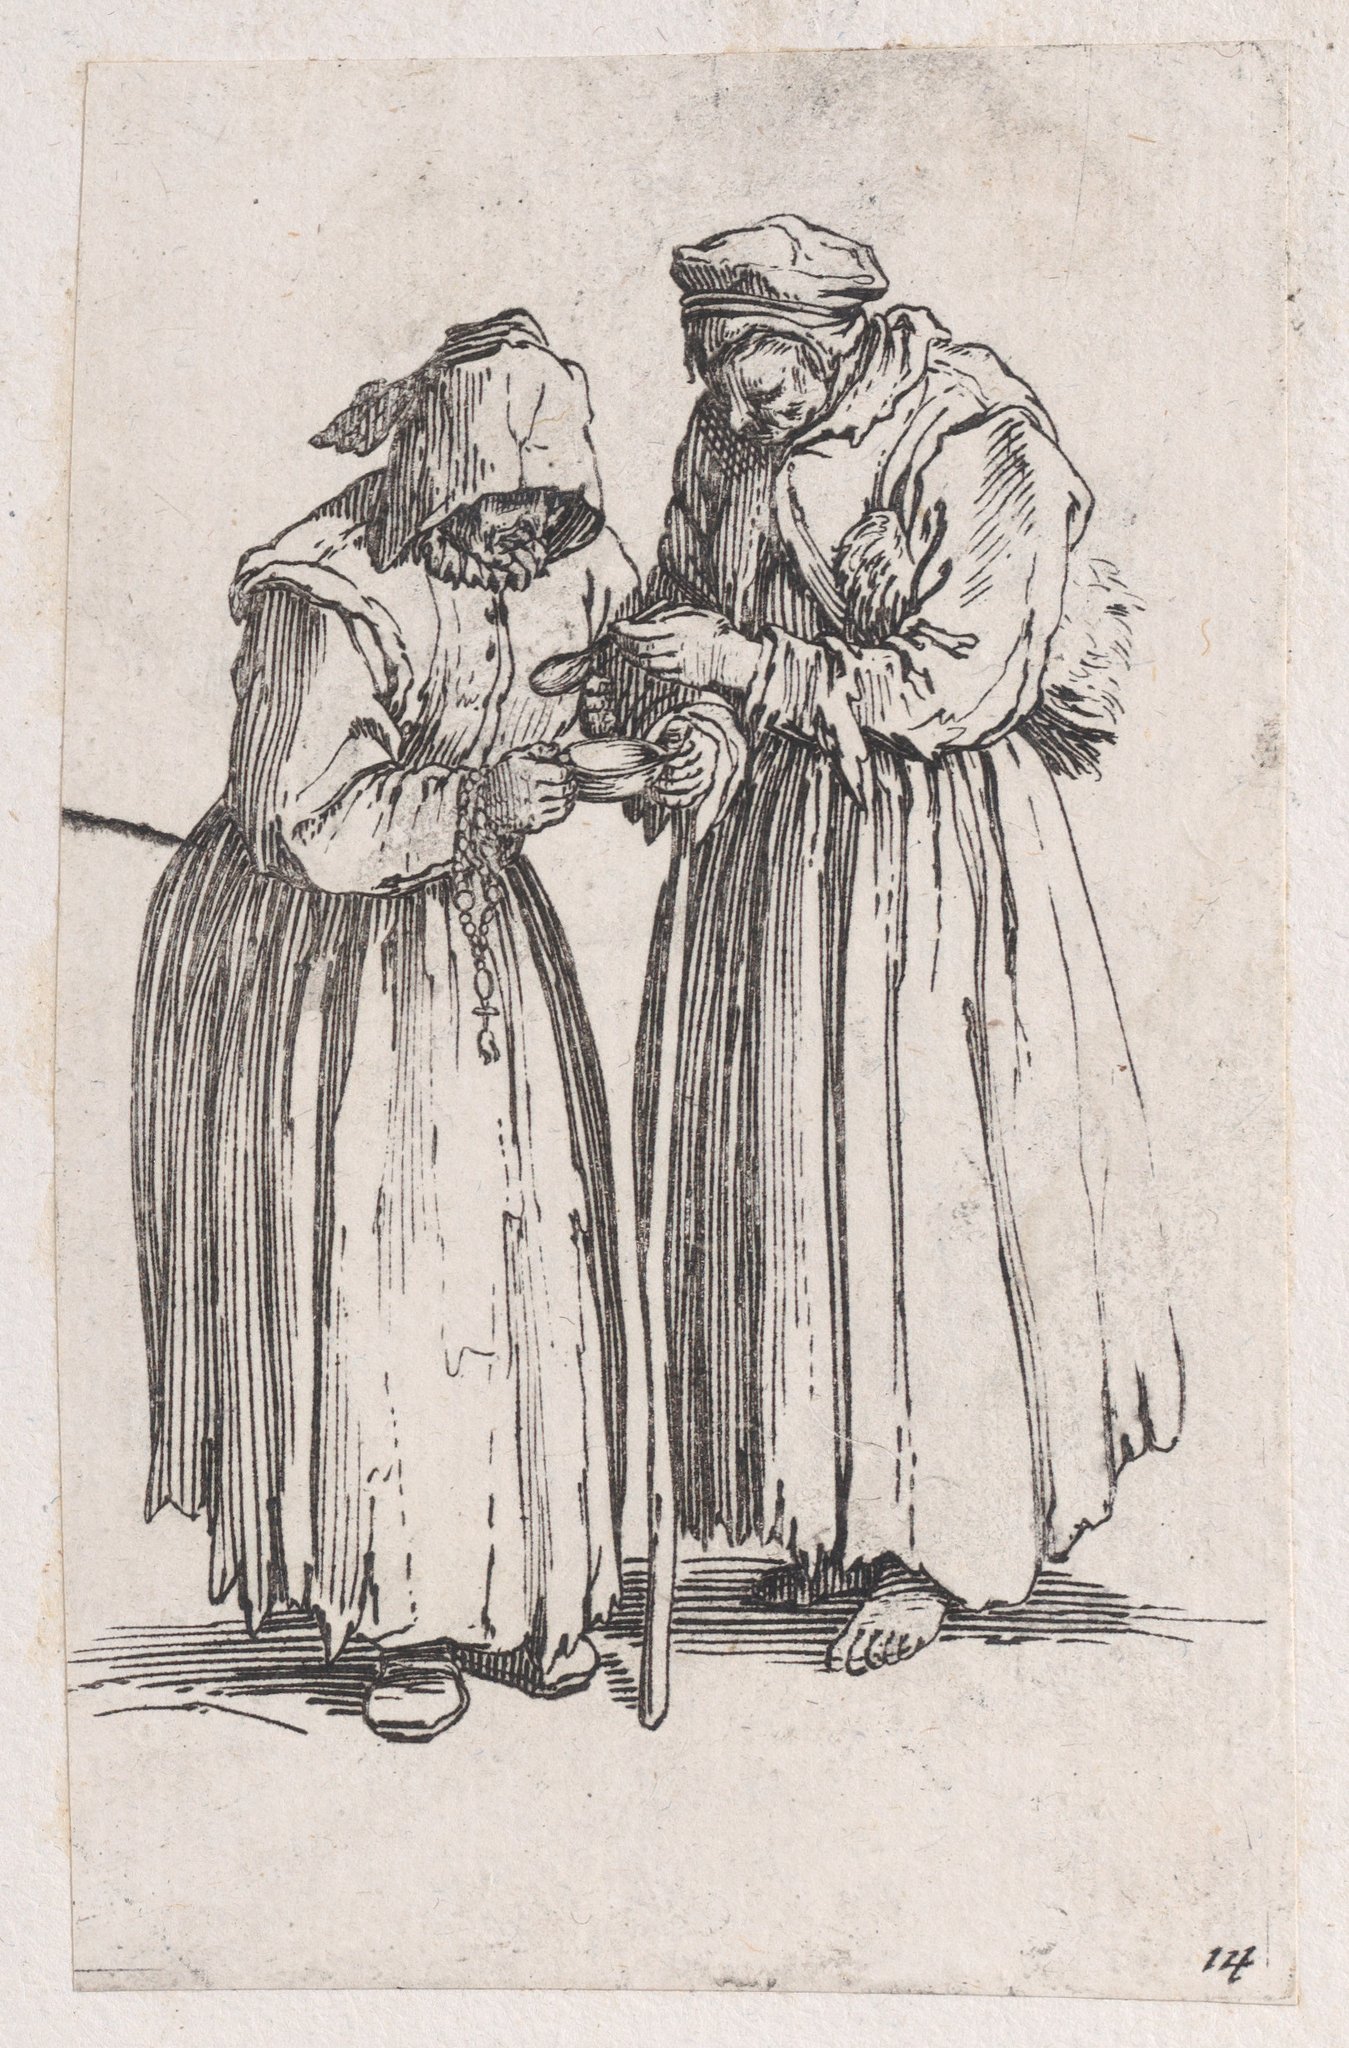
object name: print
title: Reverse Copy of Les Deux Mendiantes (The Two Female Beggars), from Les Gueux suite appelée aussi Les Mendiants, Les Baroni, ou Les Barons (The Beggars, also called the Barons)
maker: Anonymous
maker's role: artist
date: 1601-1700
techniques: etching